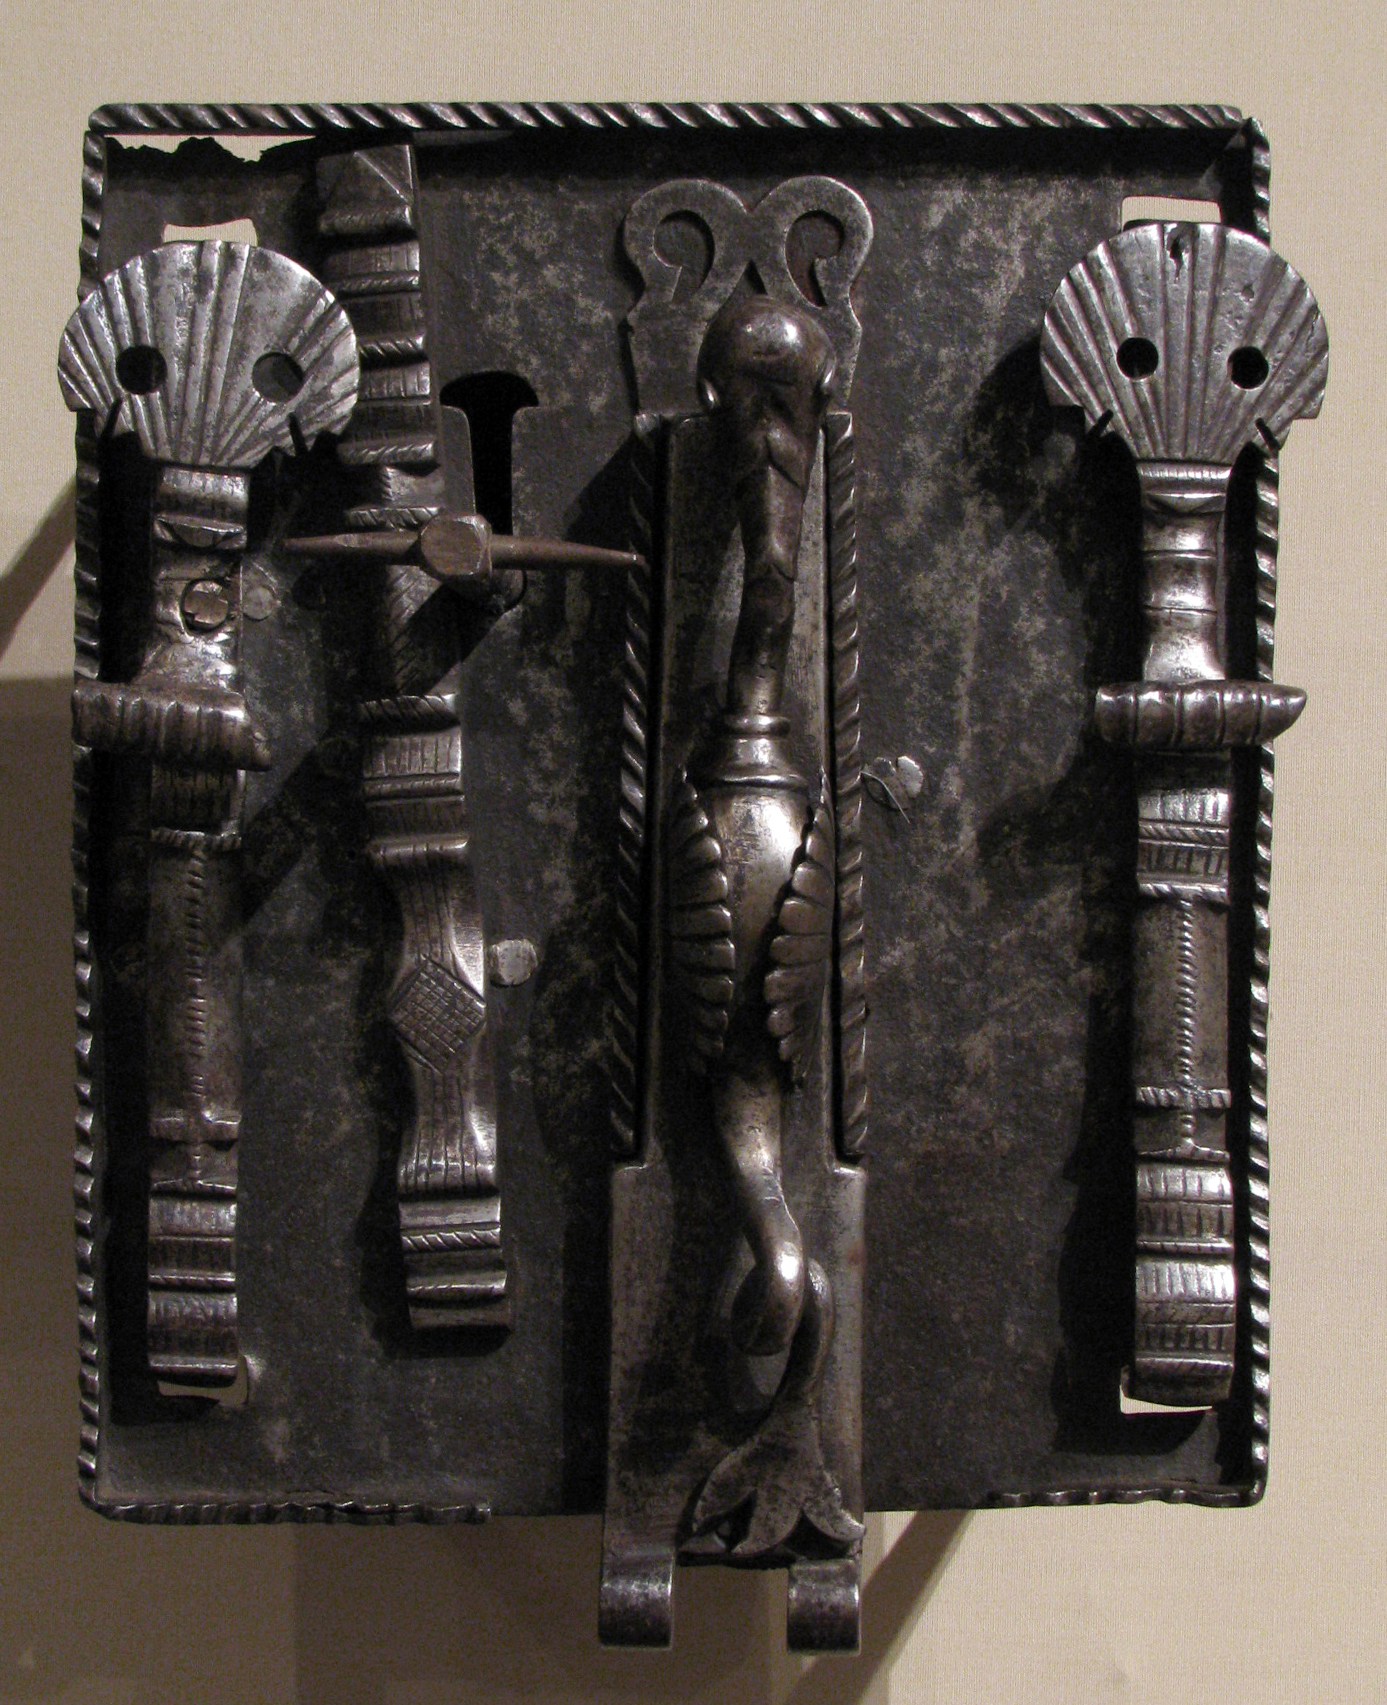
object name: coffer lock and key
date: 1501-1533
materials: iron